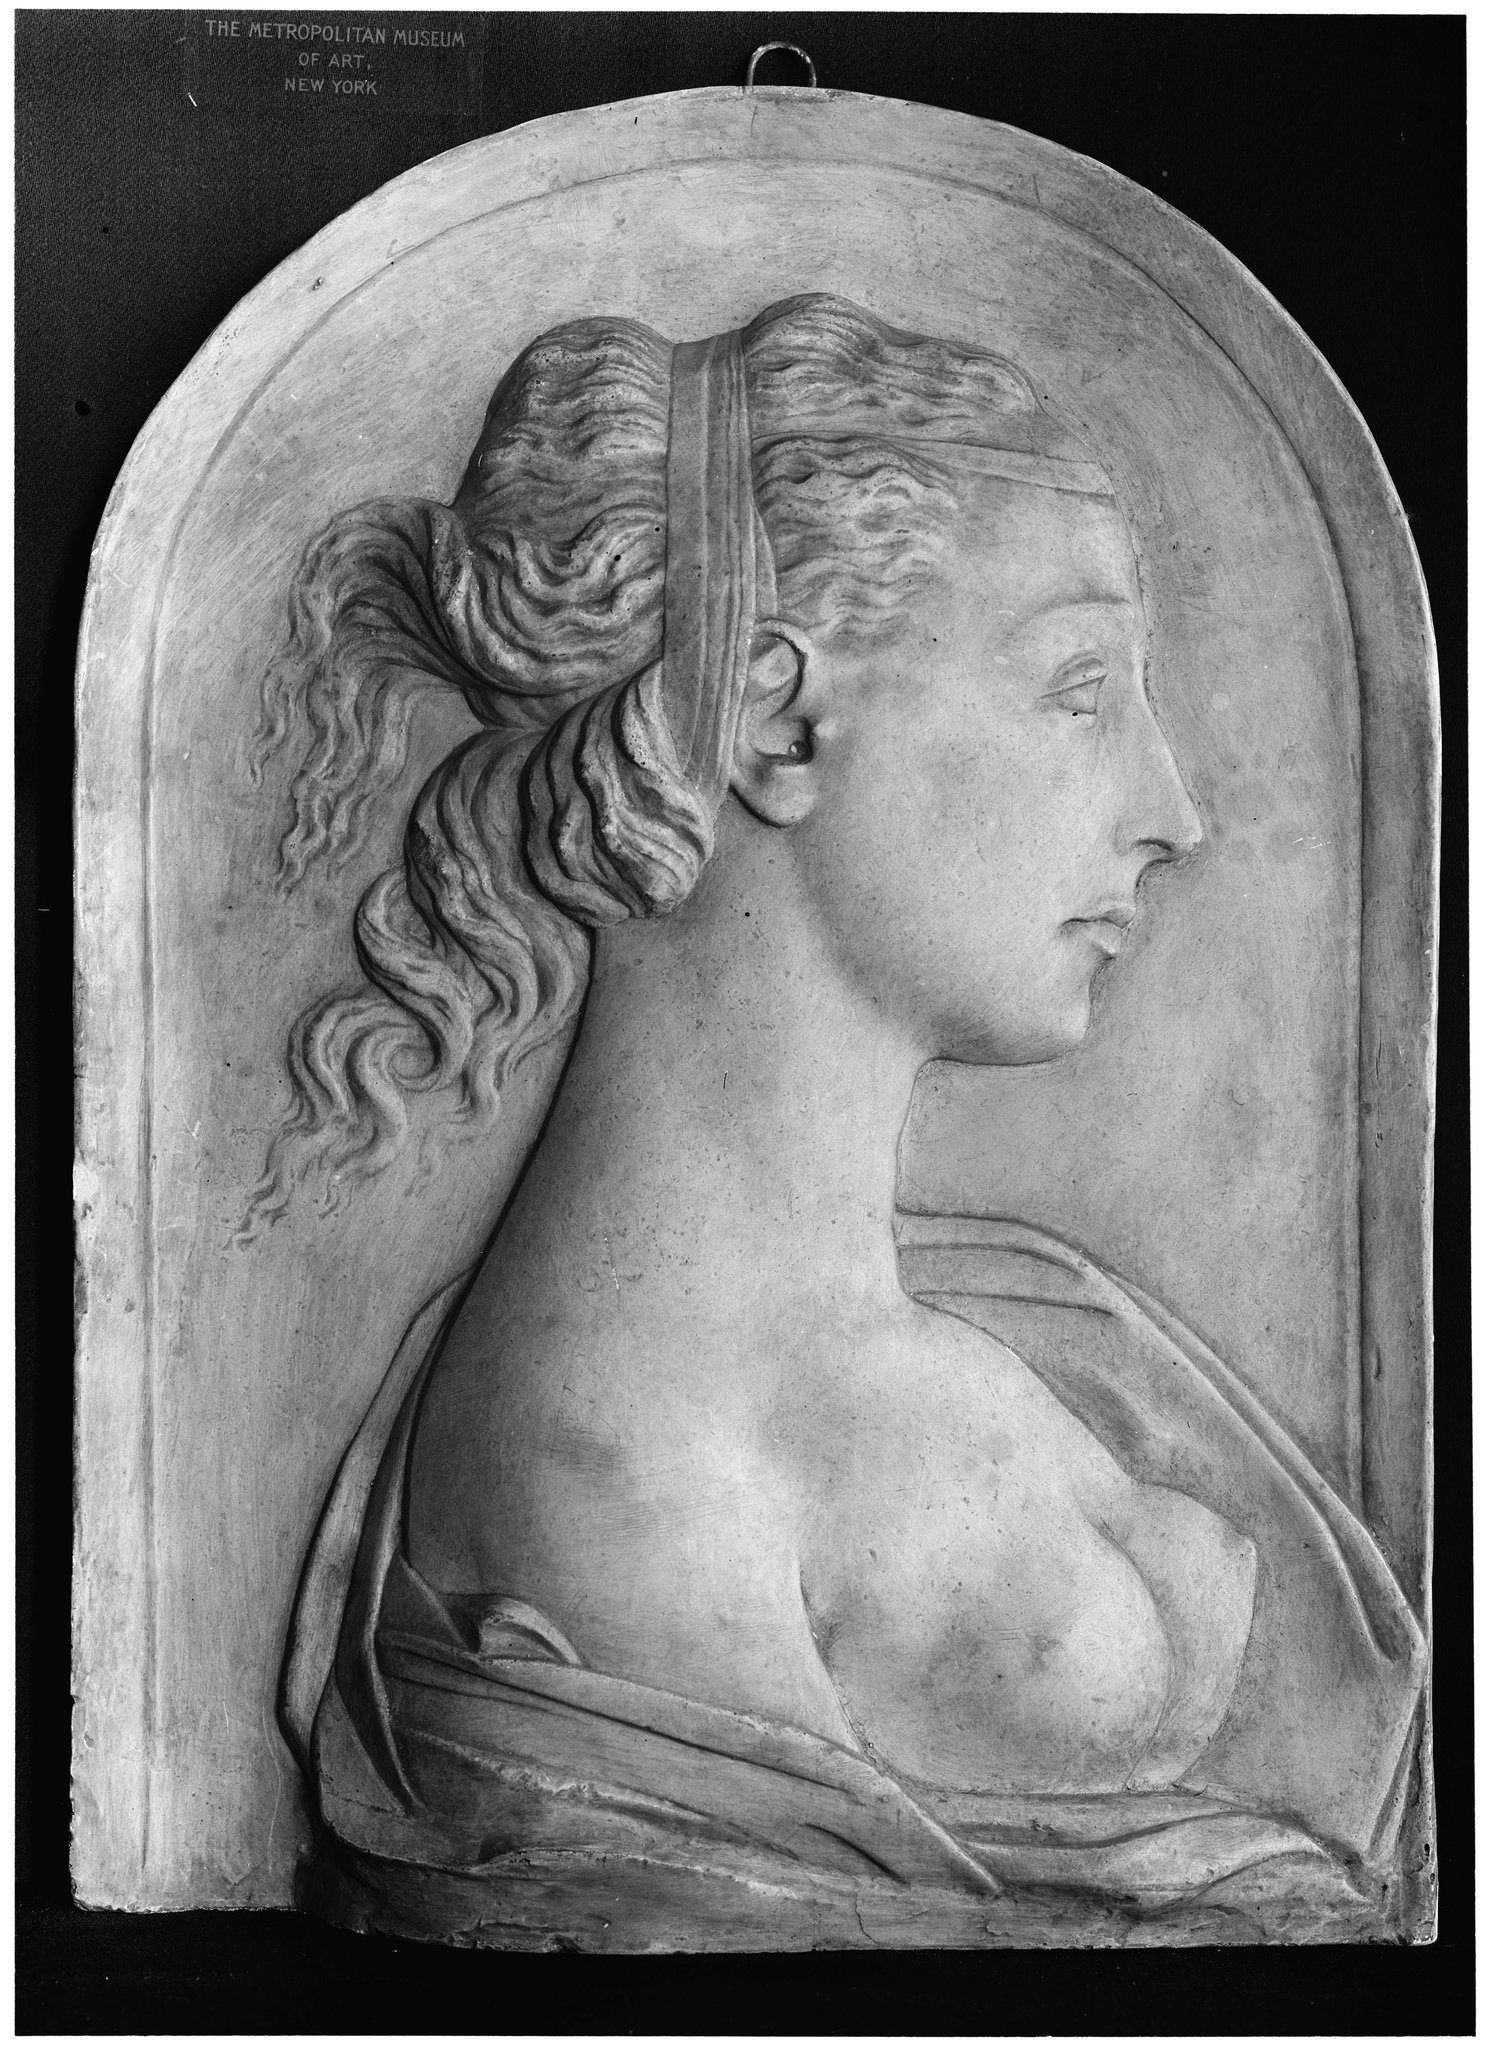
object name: relief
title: Portrait of a girl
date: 1401-1500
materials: marble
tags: girls,portraits,profiles,female nudes